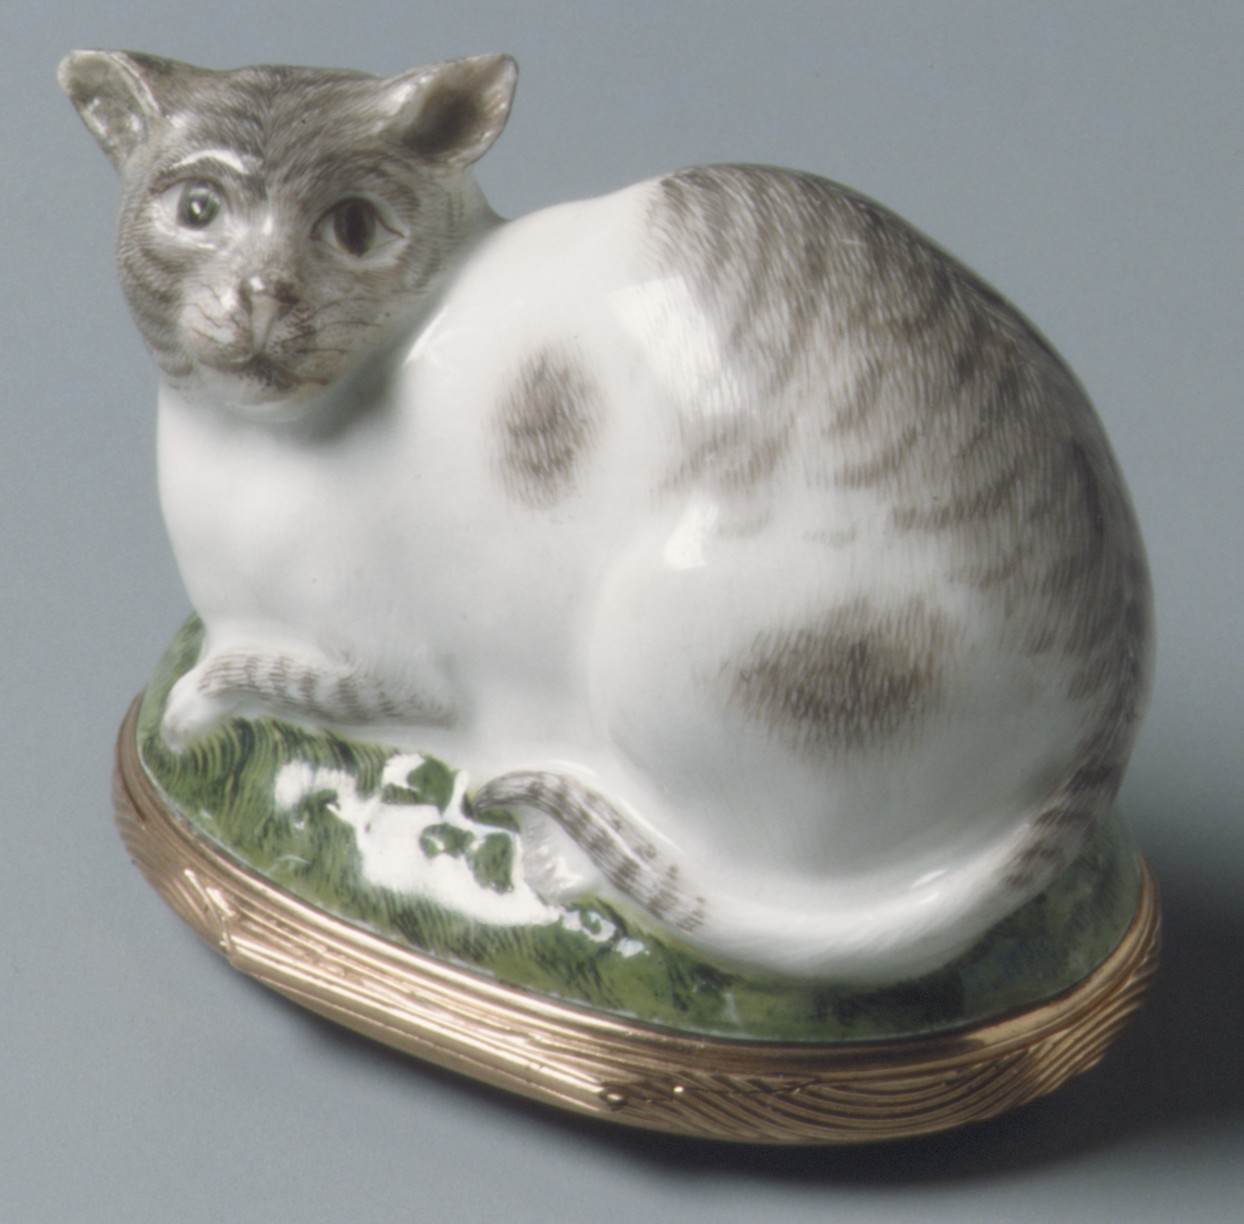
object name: snuffbox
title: Snuffbox in the form of a cat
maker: meissen manufactory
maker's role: manufactory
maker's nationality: german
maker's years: 1710-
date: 1745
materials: gold, hard paste porcelain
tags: cats